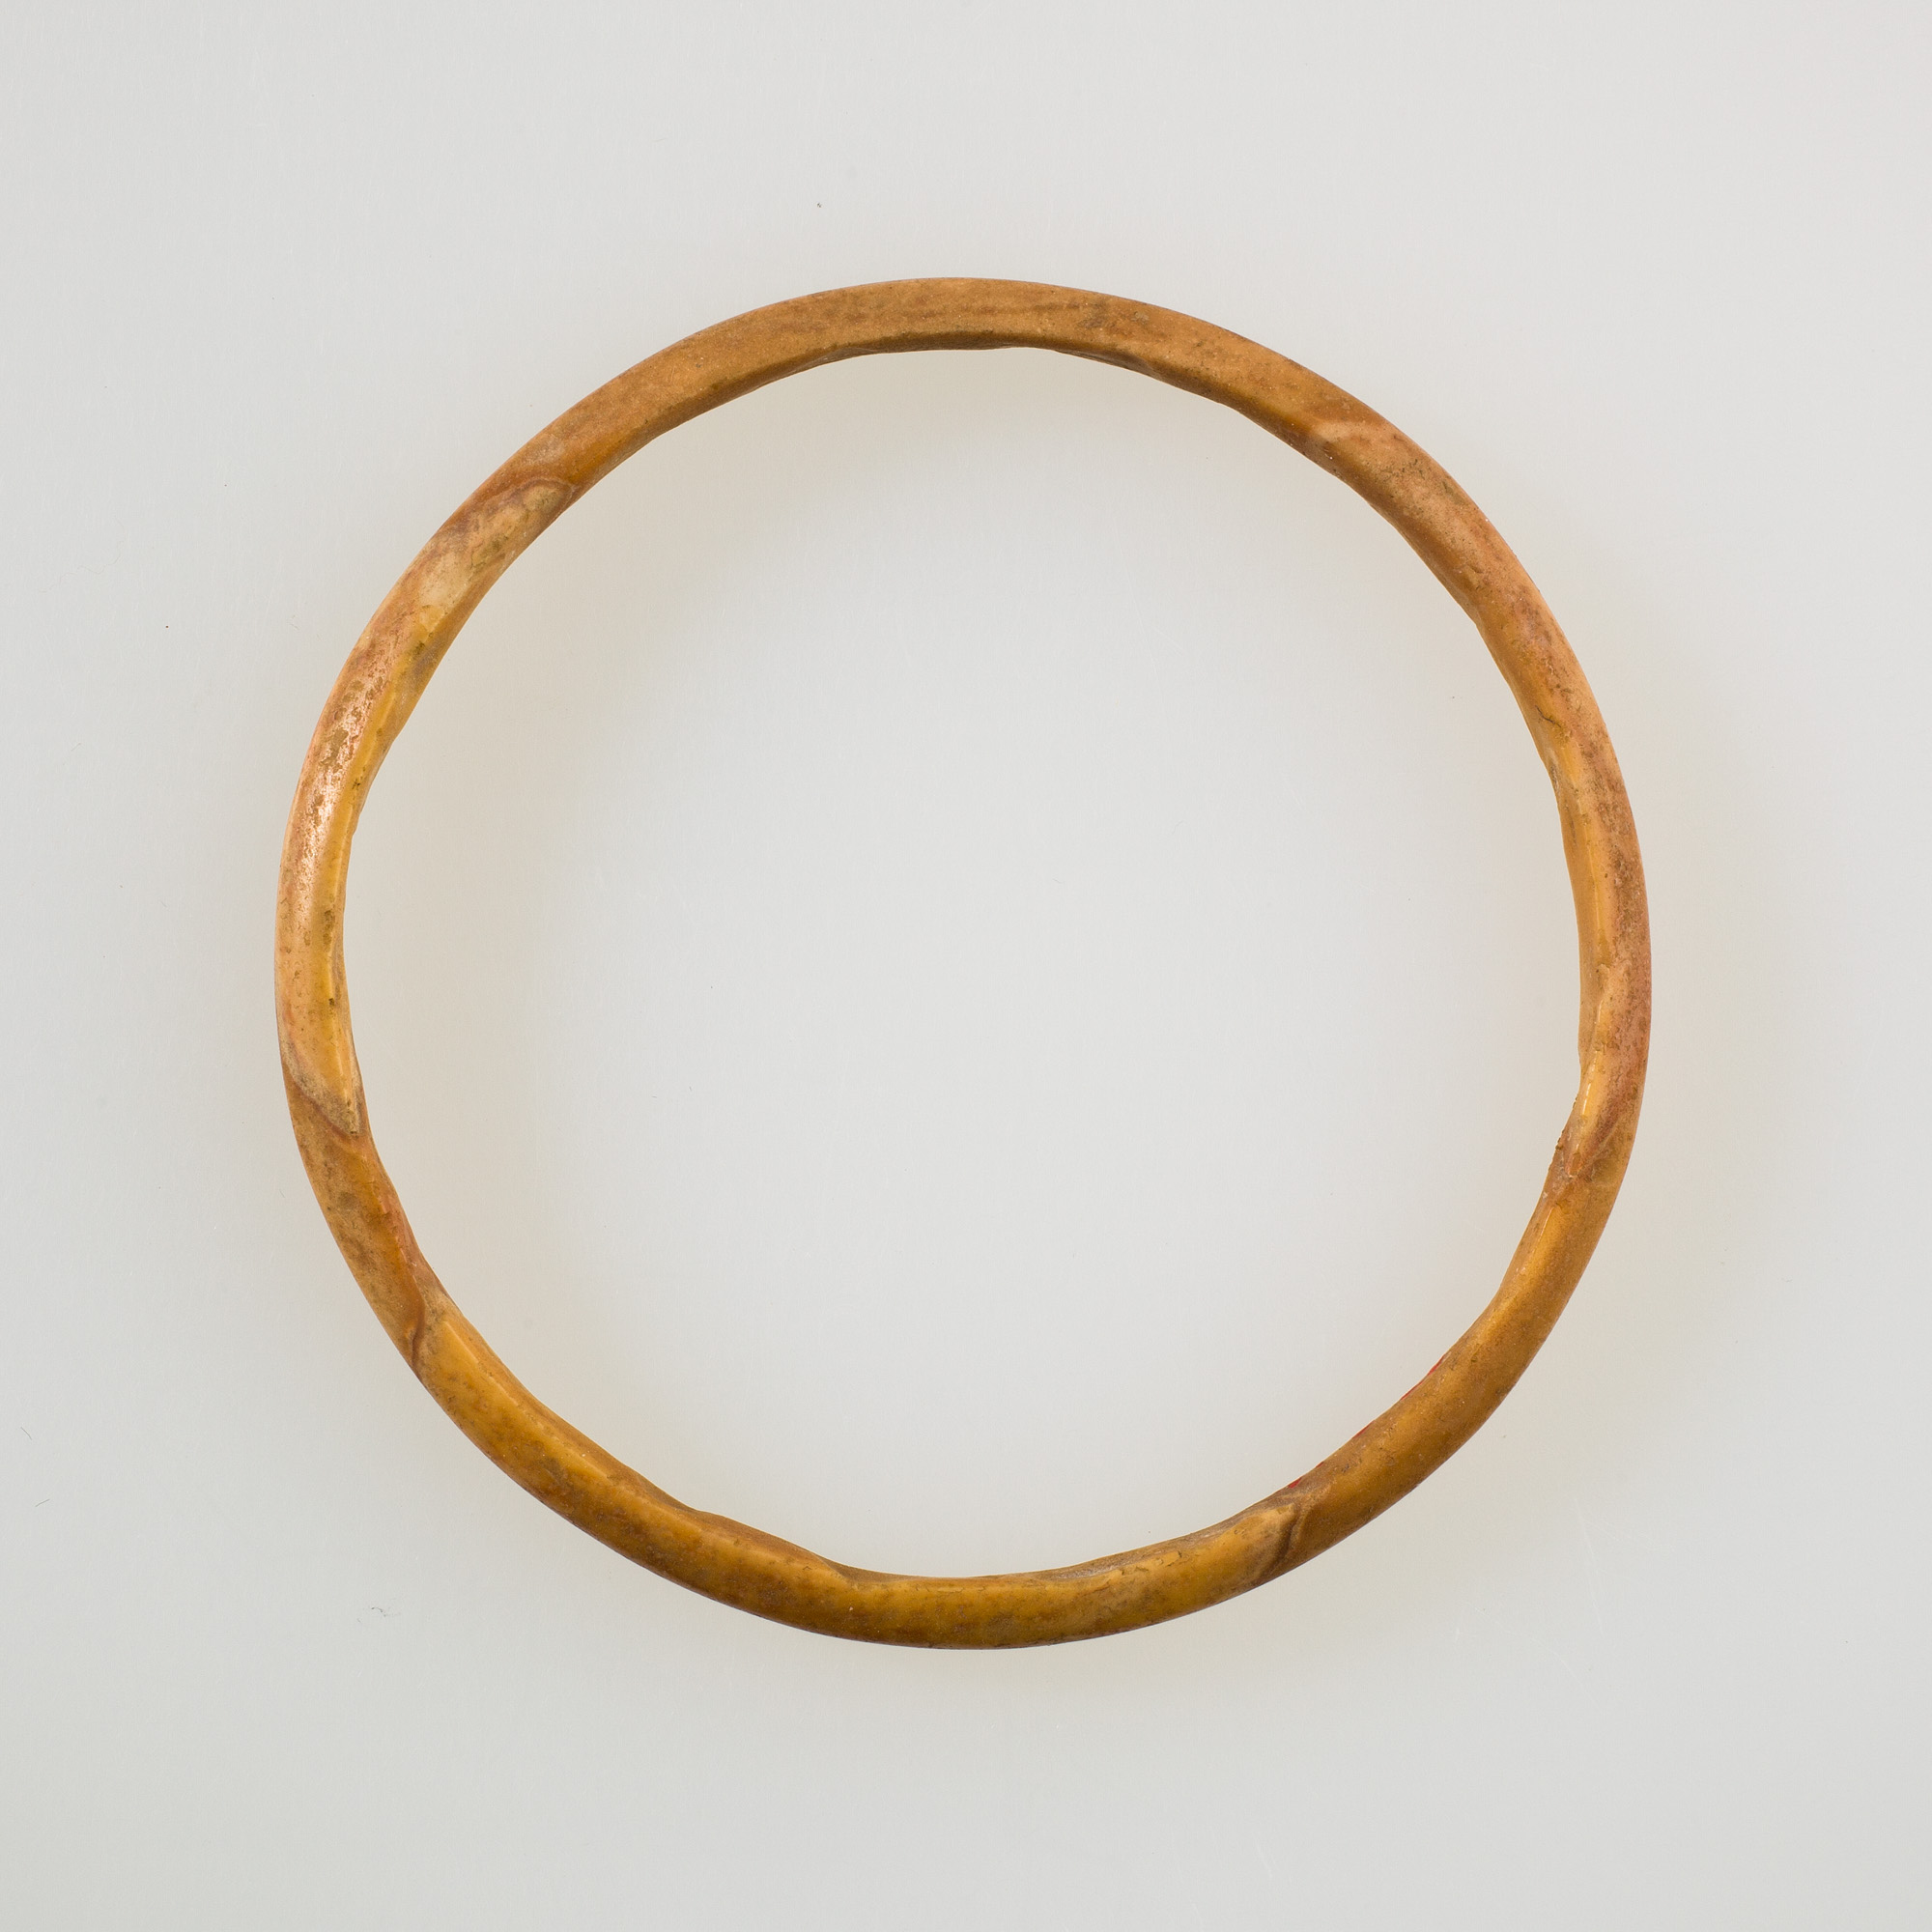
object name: bracelet bangle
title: Bracelet (Bangle)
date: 2960-2649 BCE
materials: stone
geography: egypt